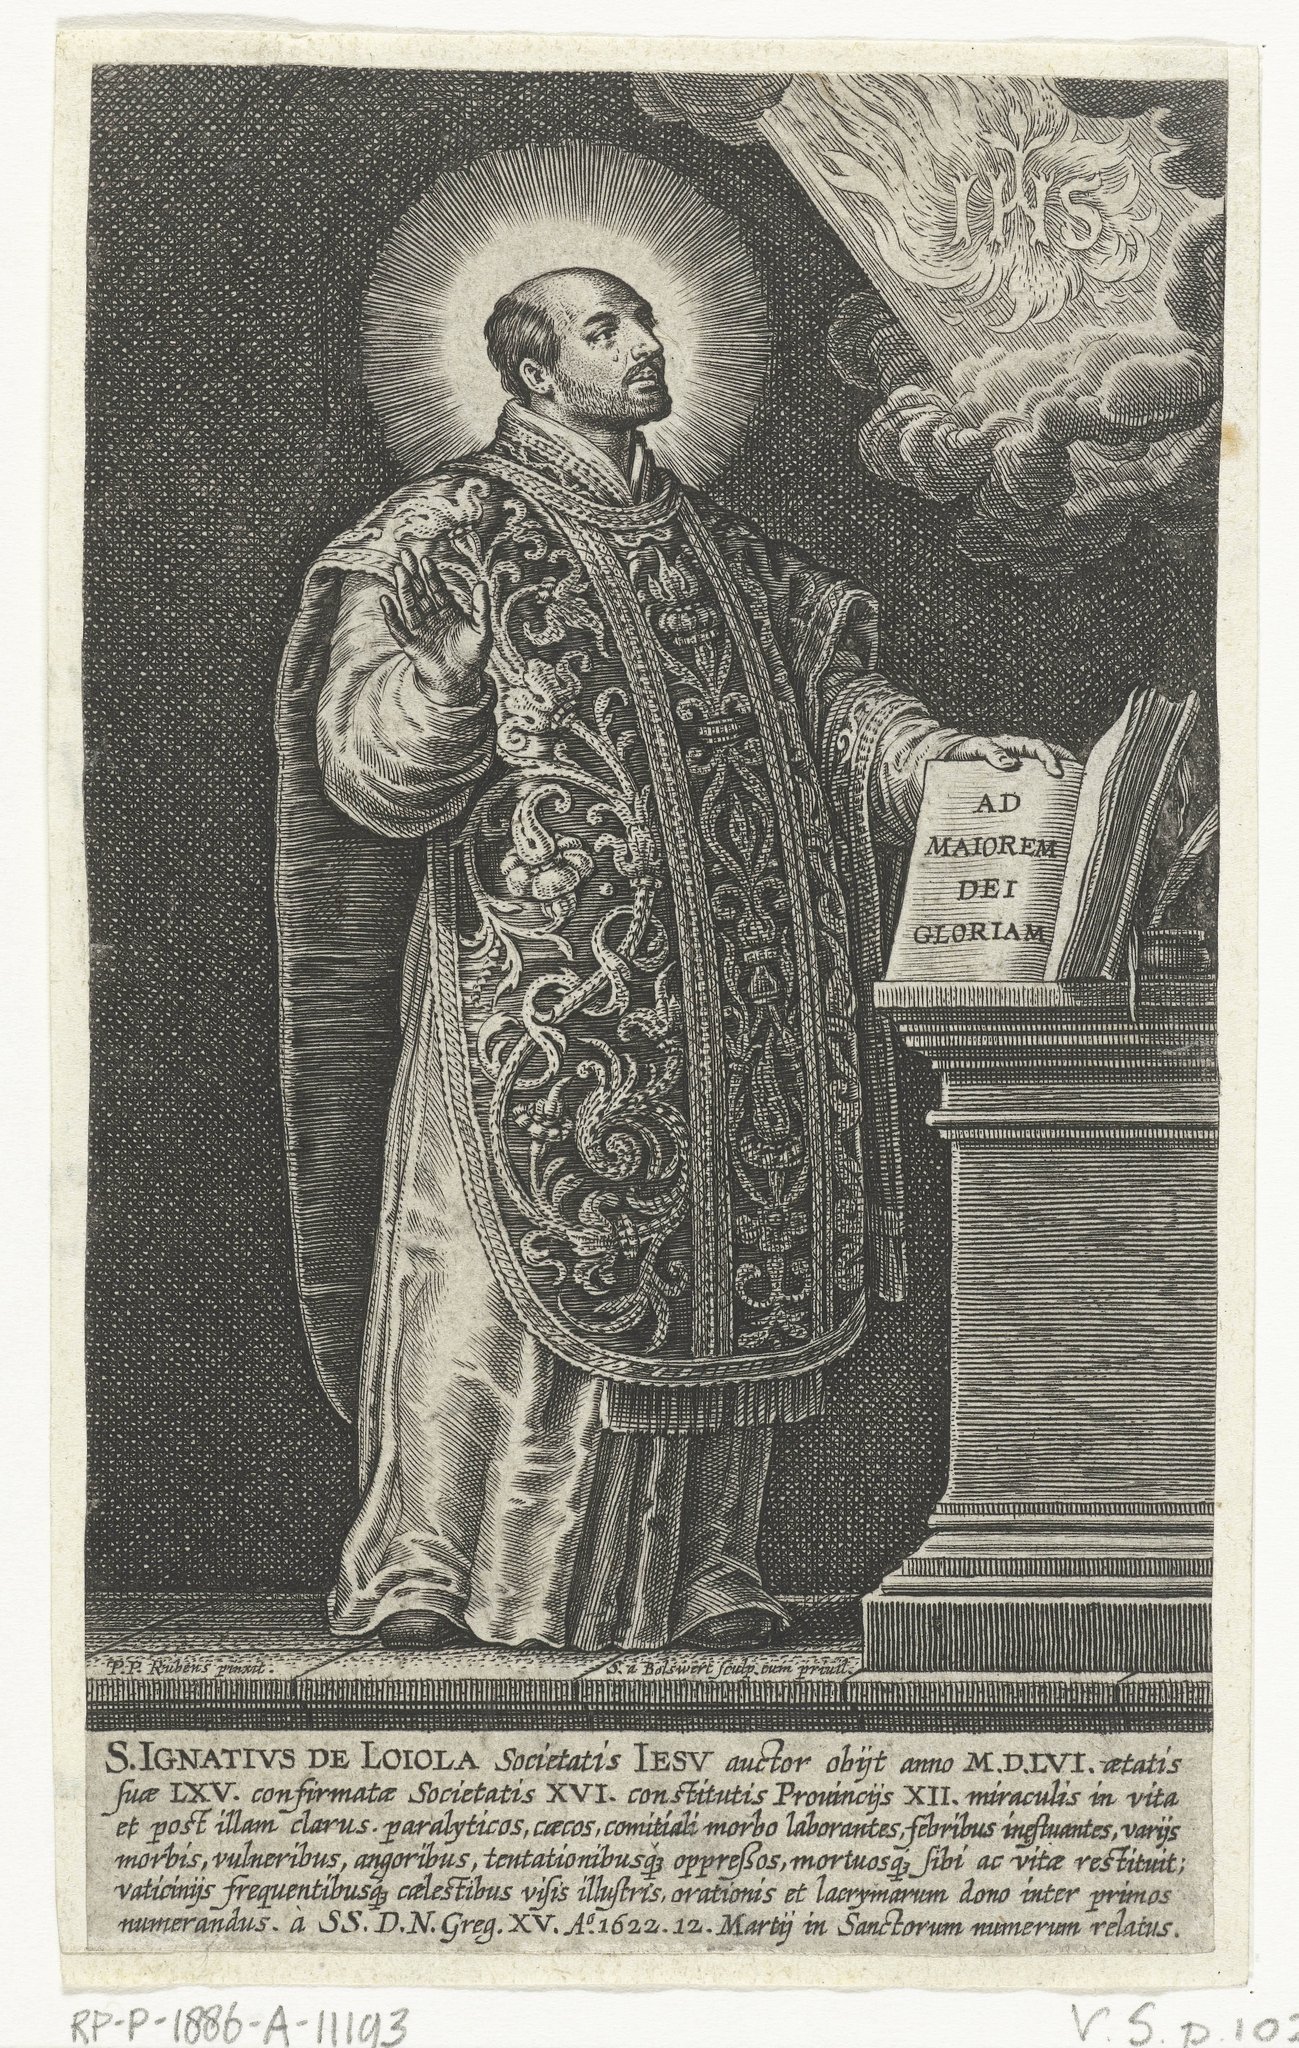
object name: print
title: Heilige Ignatius de Loyola aanbidt IHS monogram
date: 1622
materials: paper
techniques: engraving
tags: ihs ('iesus hominum salvator') ~ symbol of christ, the founder of the jesuit order, ignatius of loyola; possible attributes: book (with 'ad majorem dei gloriam'), demon, dragon under feet, flames, flaming heart, globe, ihs monogram, skull (with crown), tears in eyes, torch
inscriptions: collector's mark: Lugt 2228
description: De heilige Ignatius de Loyola aanbidt het IHS monogram dat in de hemel verschijnt. Onder de voorstelling staat een tekst in het Latijn over de verdiensten van de heilige.